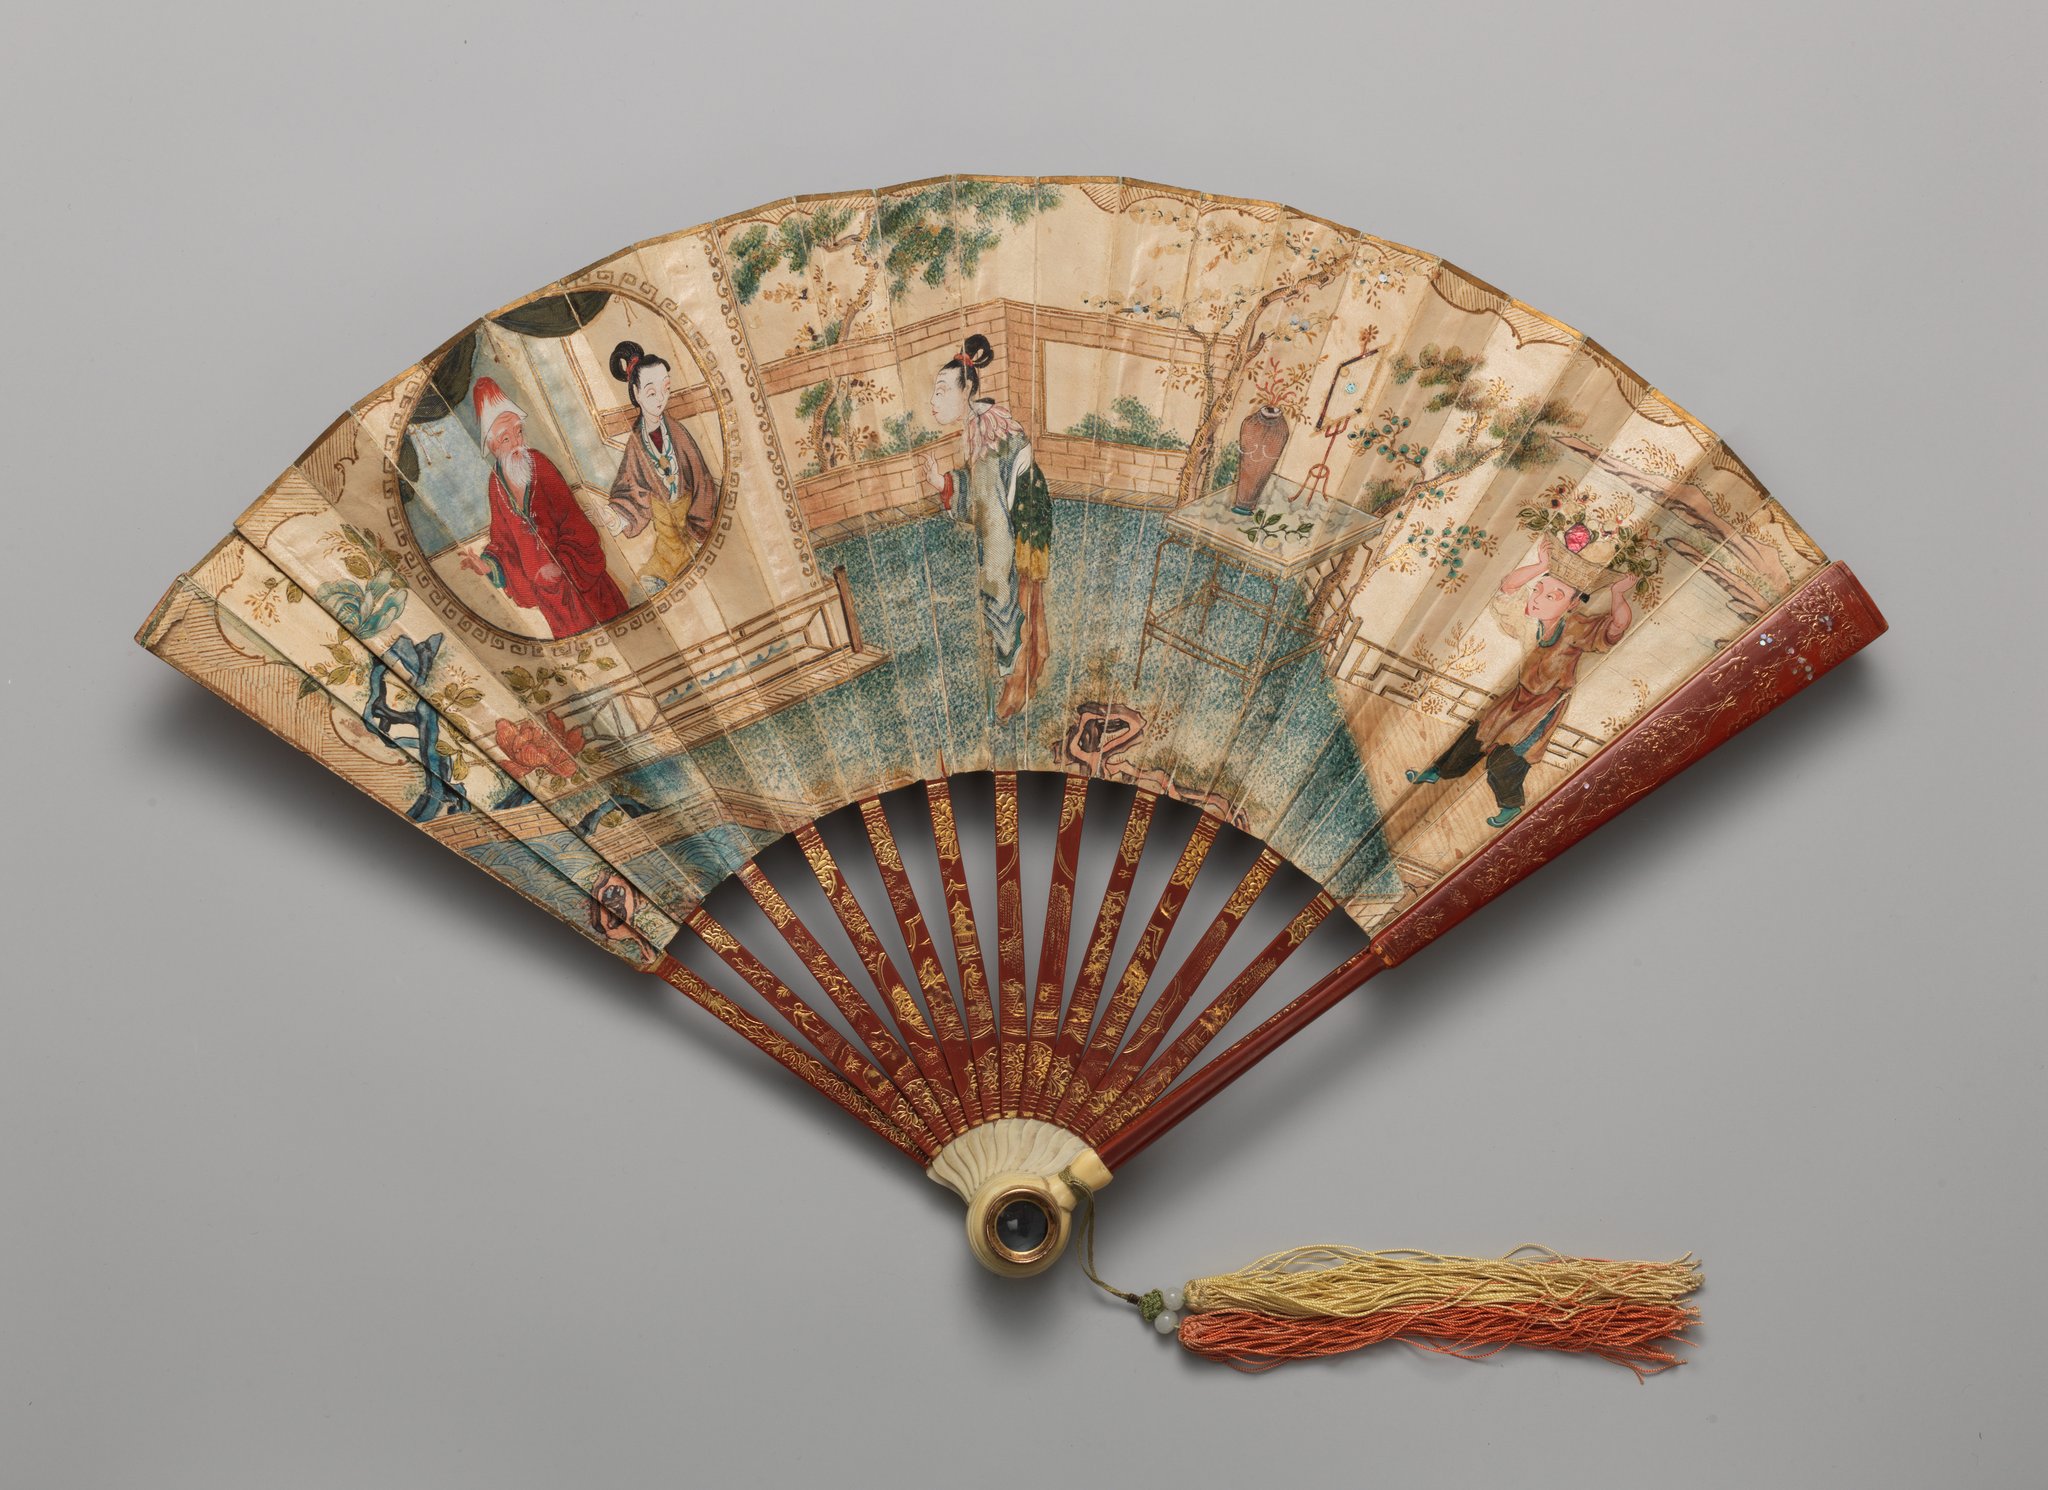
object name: fan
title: Lorgnette Fan with Scene of Figures in a Courtyard Garden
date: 1734-1766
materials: gold, ivory, paper, silk, watercolor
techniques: gilding, highlighting, lacquer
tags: men,women